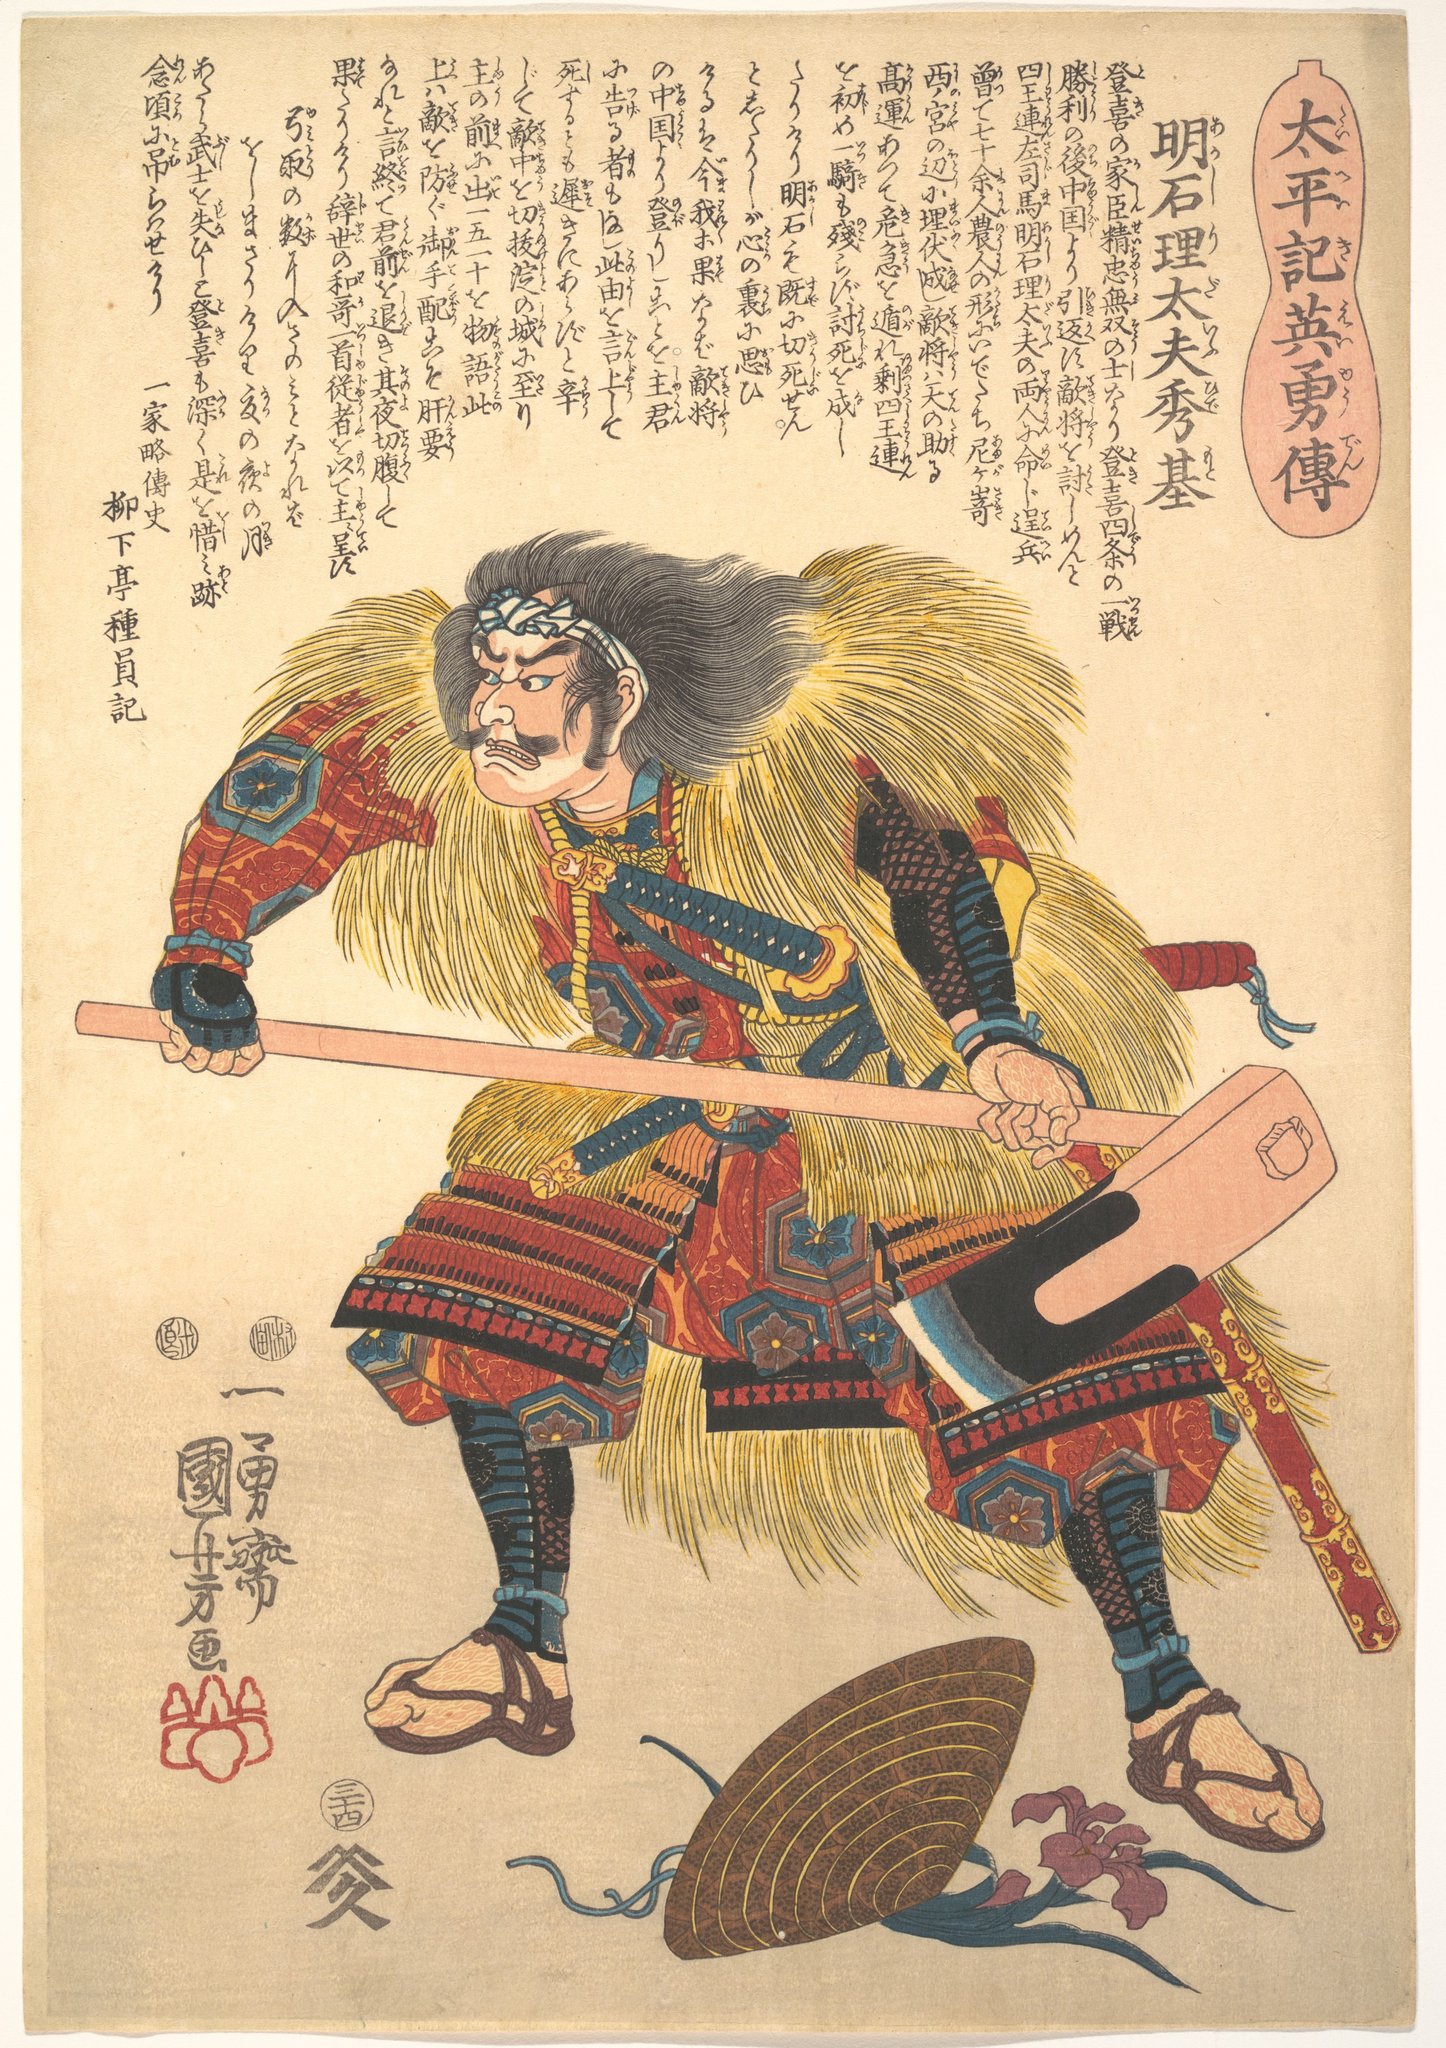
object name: print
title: Akashi Ridayu Hidemoto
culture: japanese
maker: utagawa kuniyoshi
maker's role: artist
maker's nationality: japanese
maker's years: 1797-1861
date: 1848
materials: ink, paper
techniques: woodblock print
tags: weapons,men